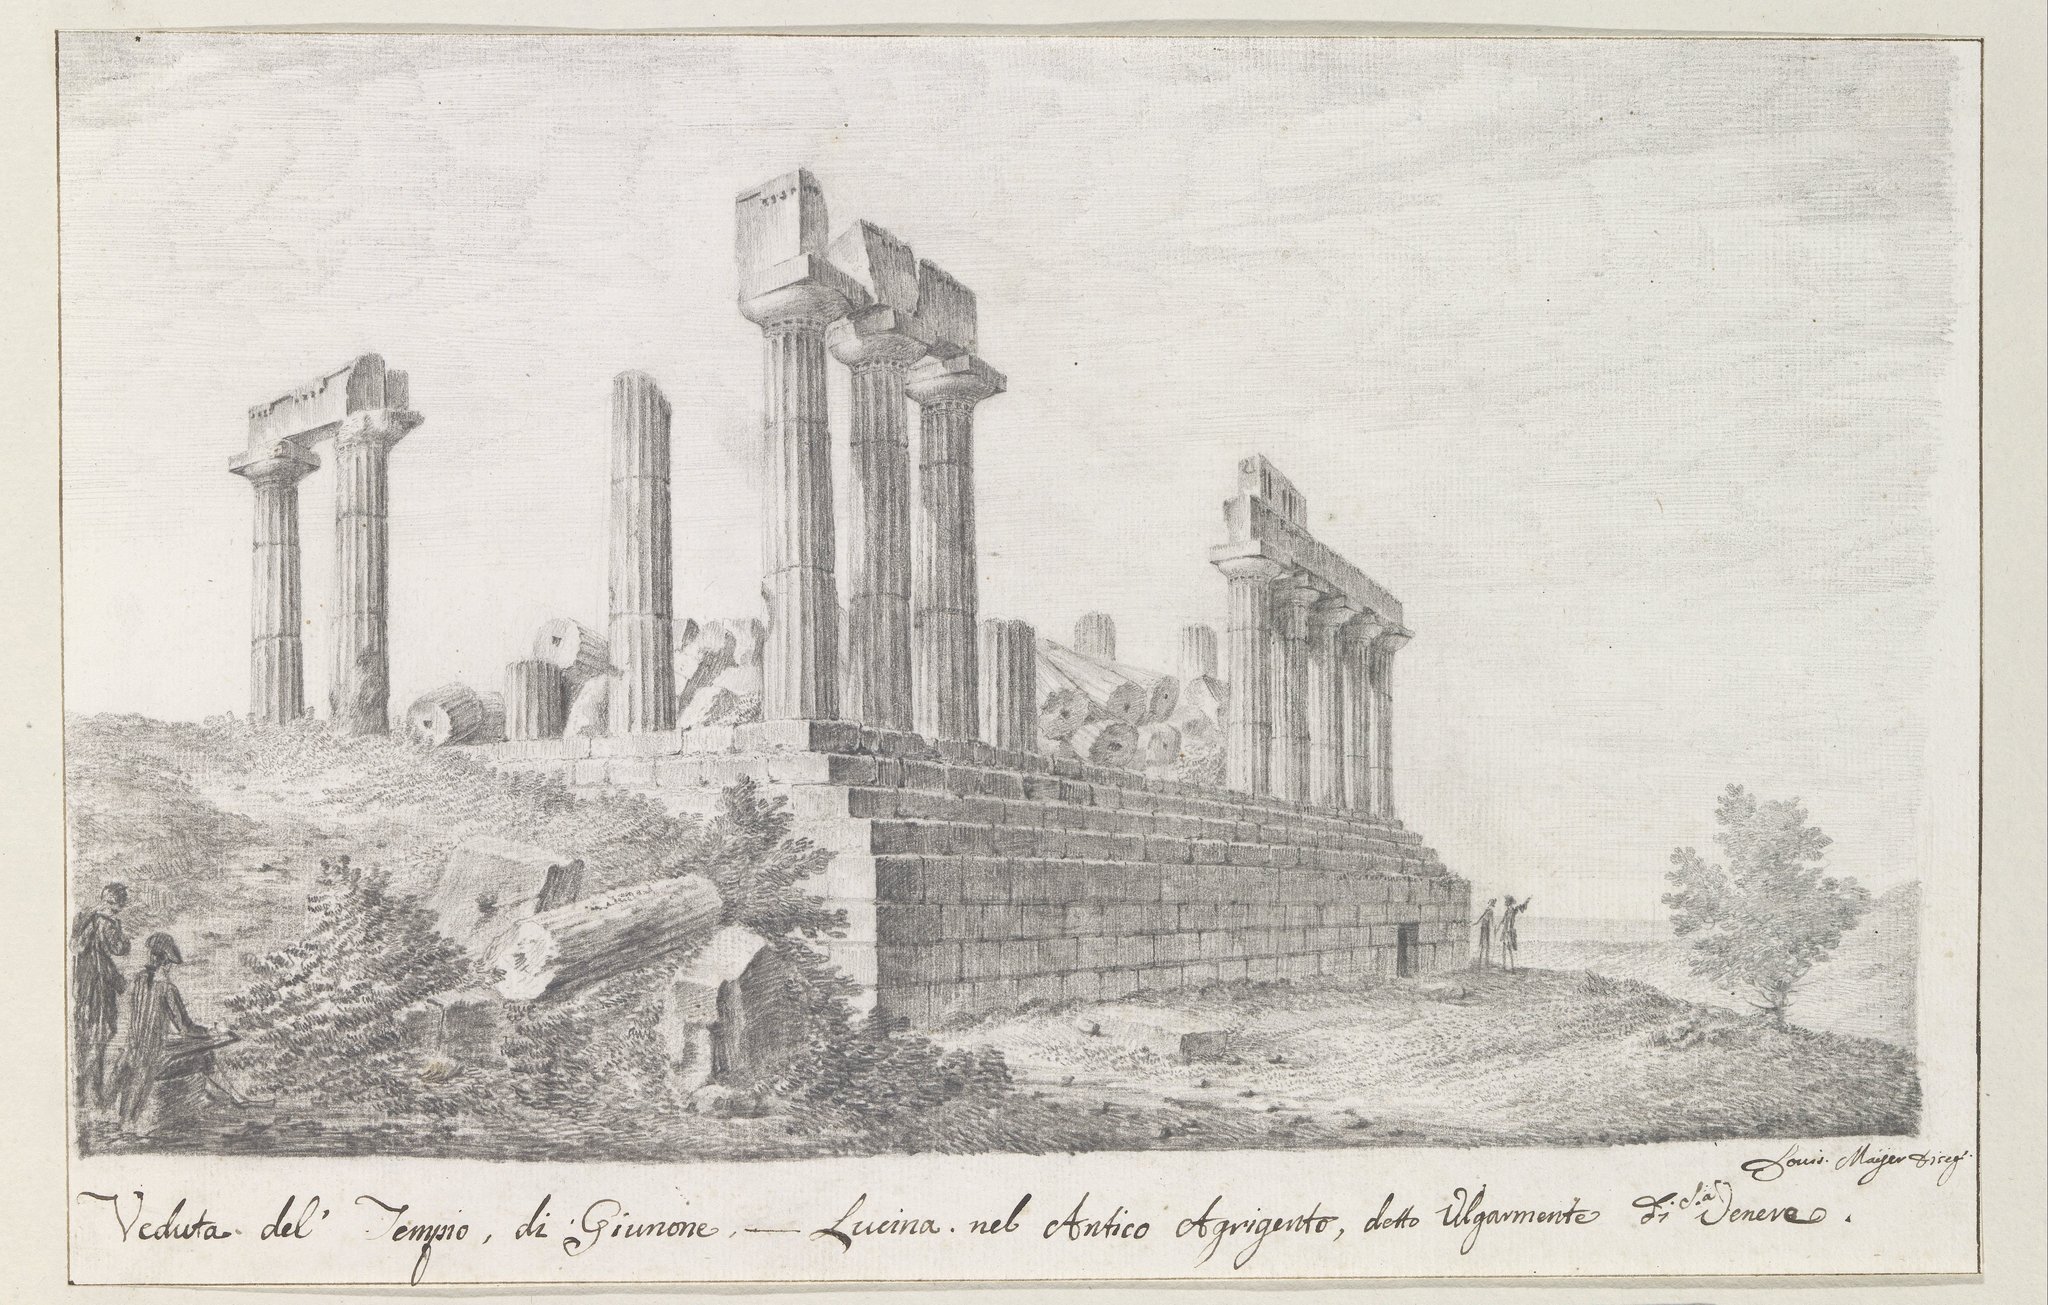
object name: drawing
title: Veduta del Tempio di Giunone Lucina nel Antico Agrigento, detto volgarmente di Sa. Venere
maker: louis mayer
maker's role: draughtsman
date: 1778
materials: chalk, paper, pencil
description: Tekening uit het album 'Voyage en Italie, en Sicile et à Malte', 1778.